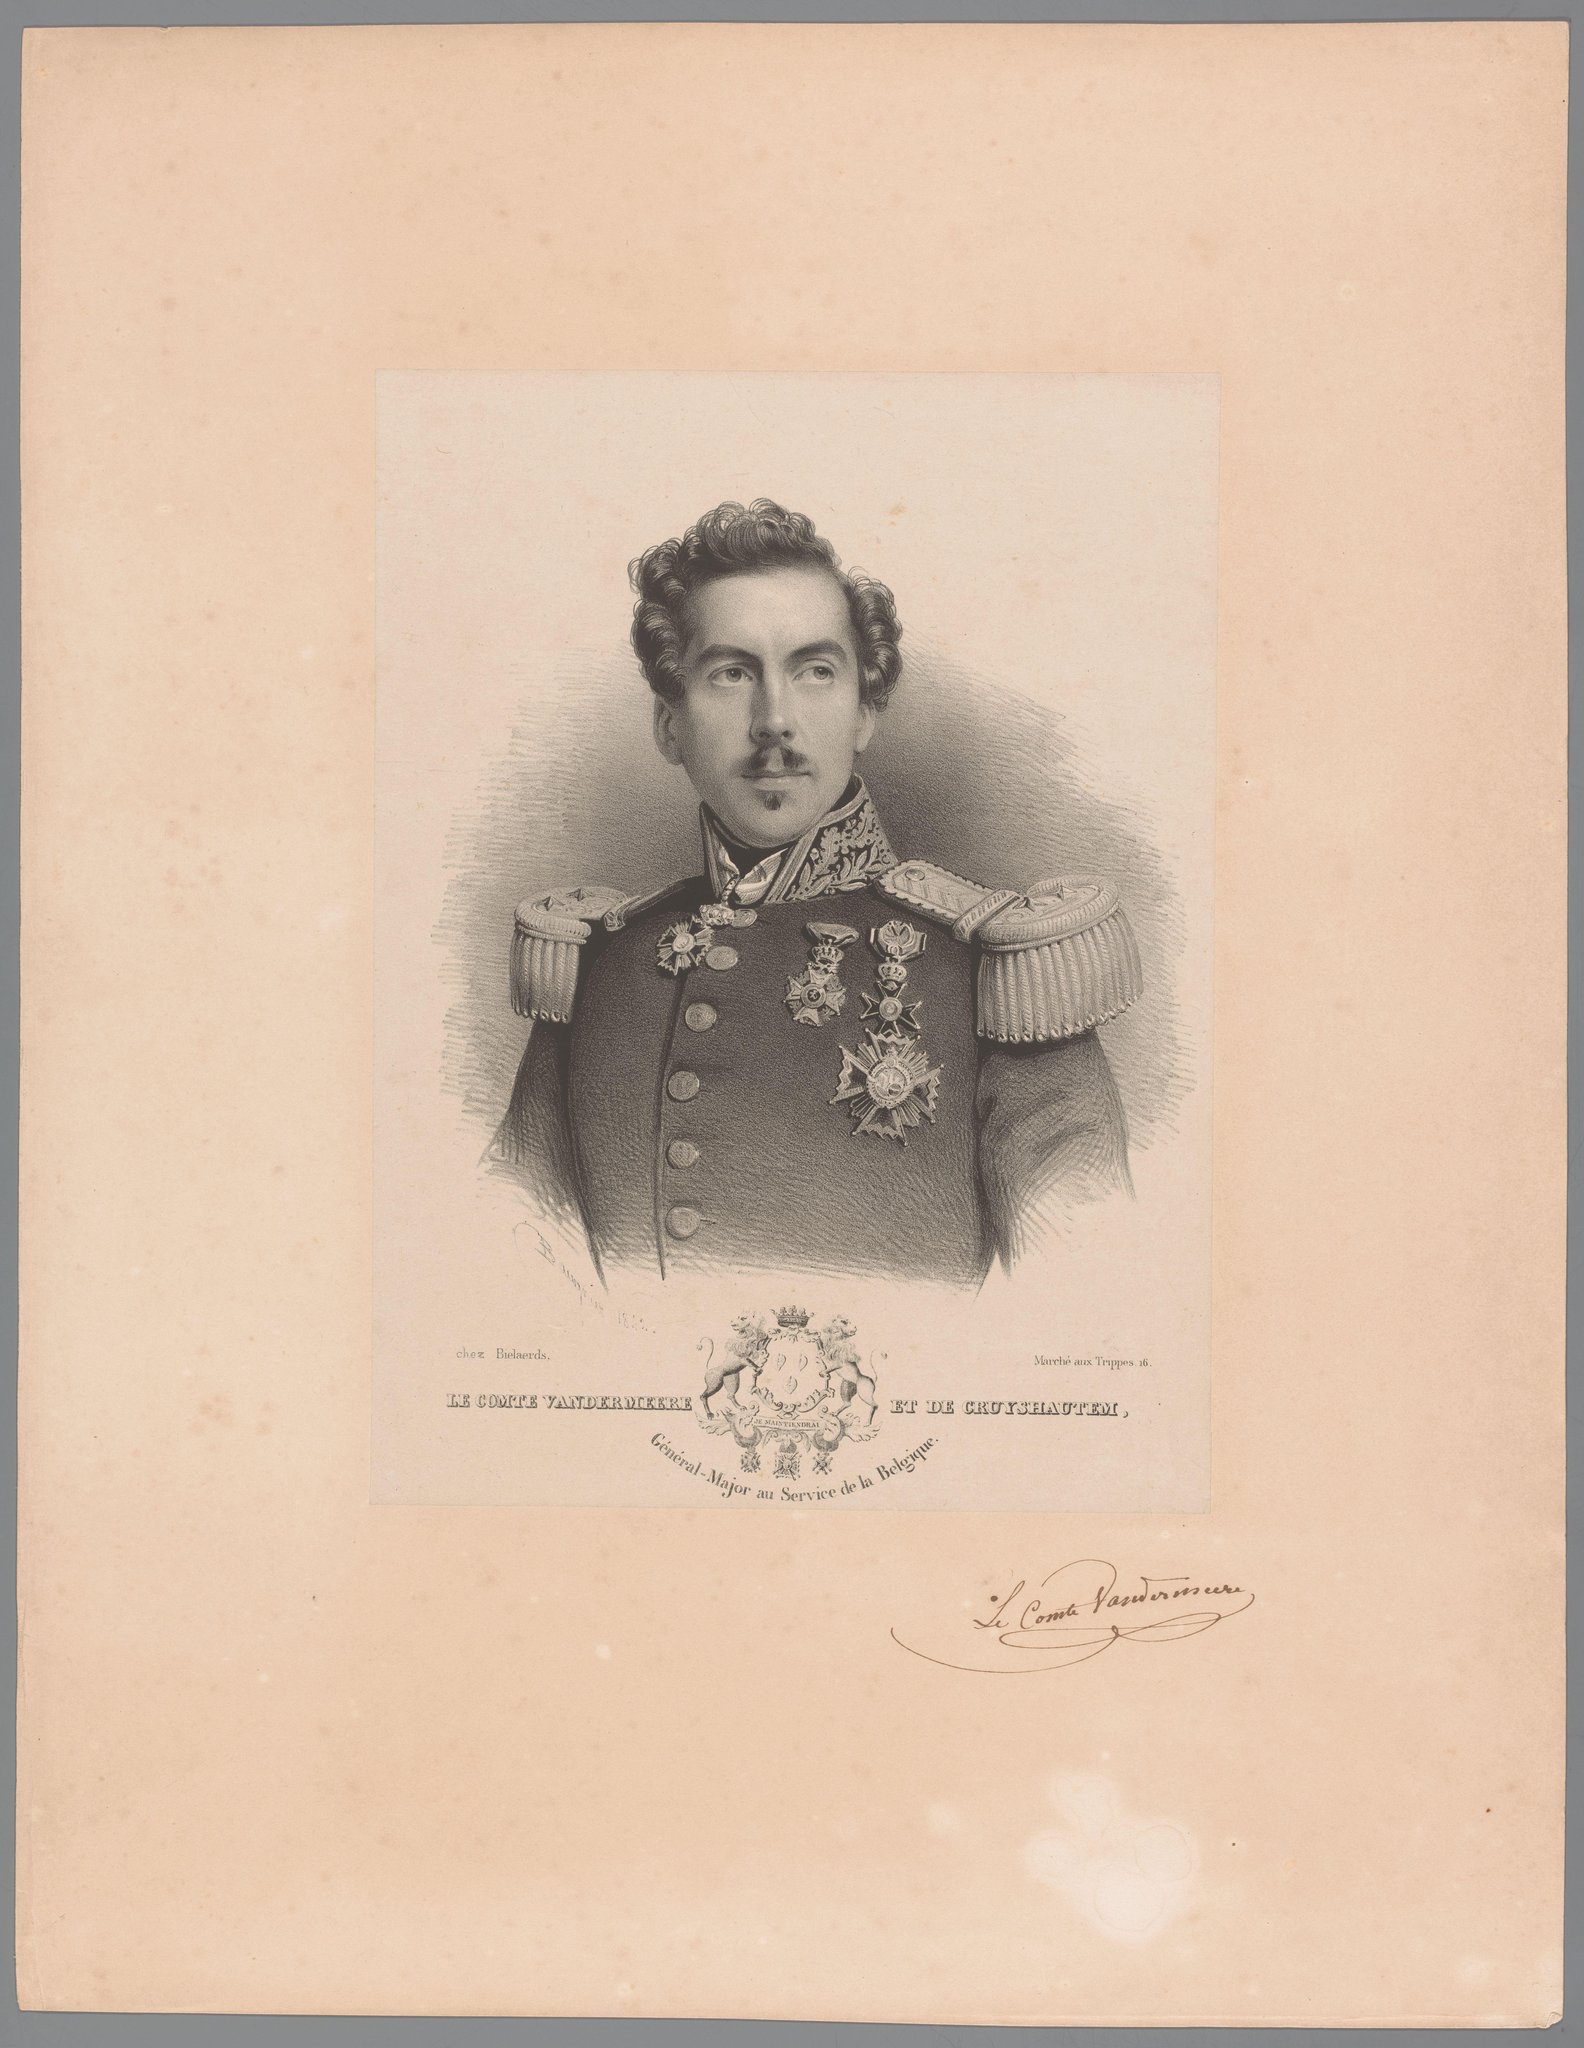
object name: print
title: Portret van graaf Van der Meere en Cruyshautem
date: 1842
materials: paper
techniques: lithograph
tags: adult man, historical persons, armorial bearing, heraldry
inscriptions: inscription: ‘Le comte Vandermeere’, collector's mark: Lugt 2228